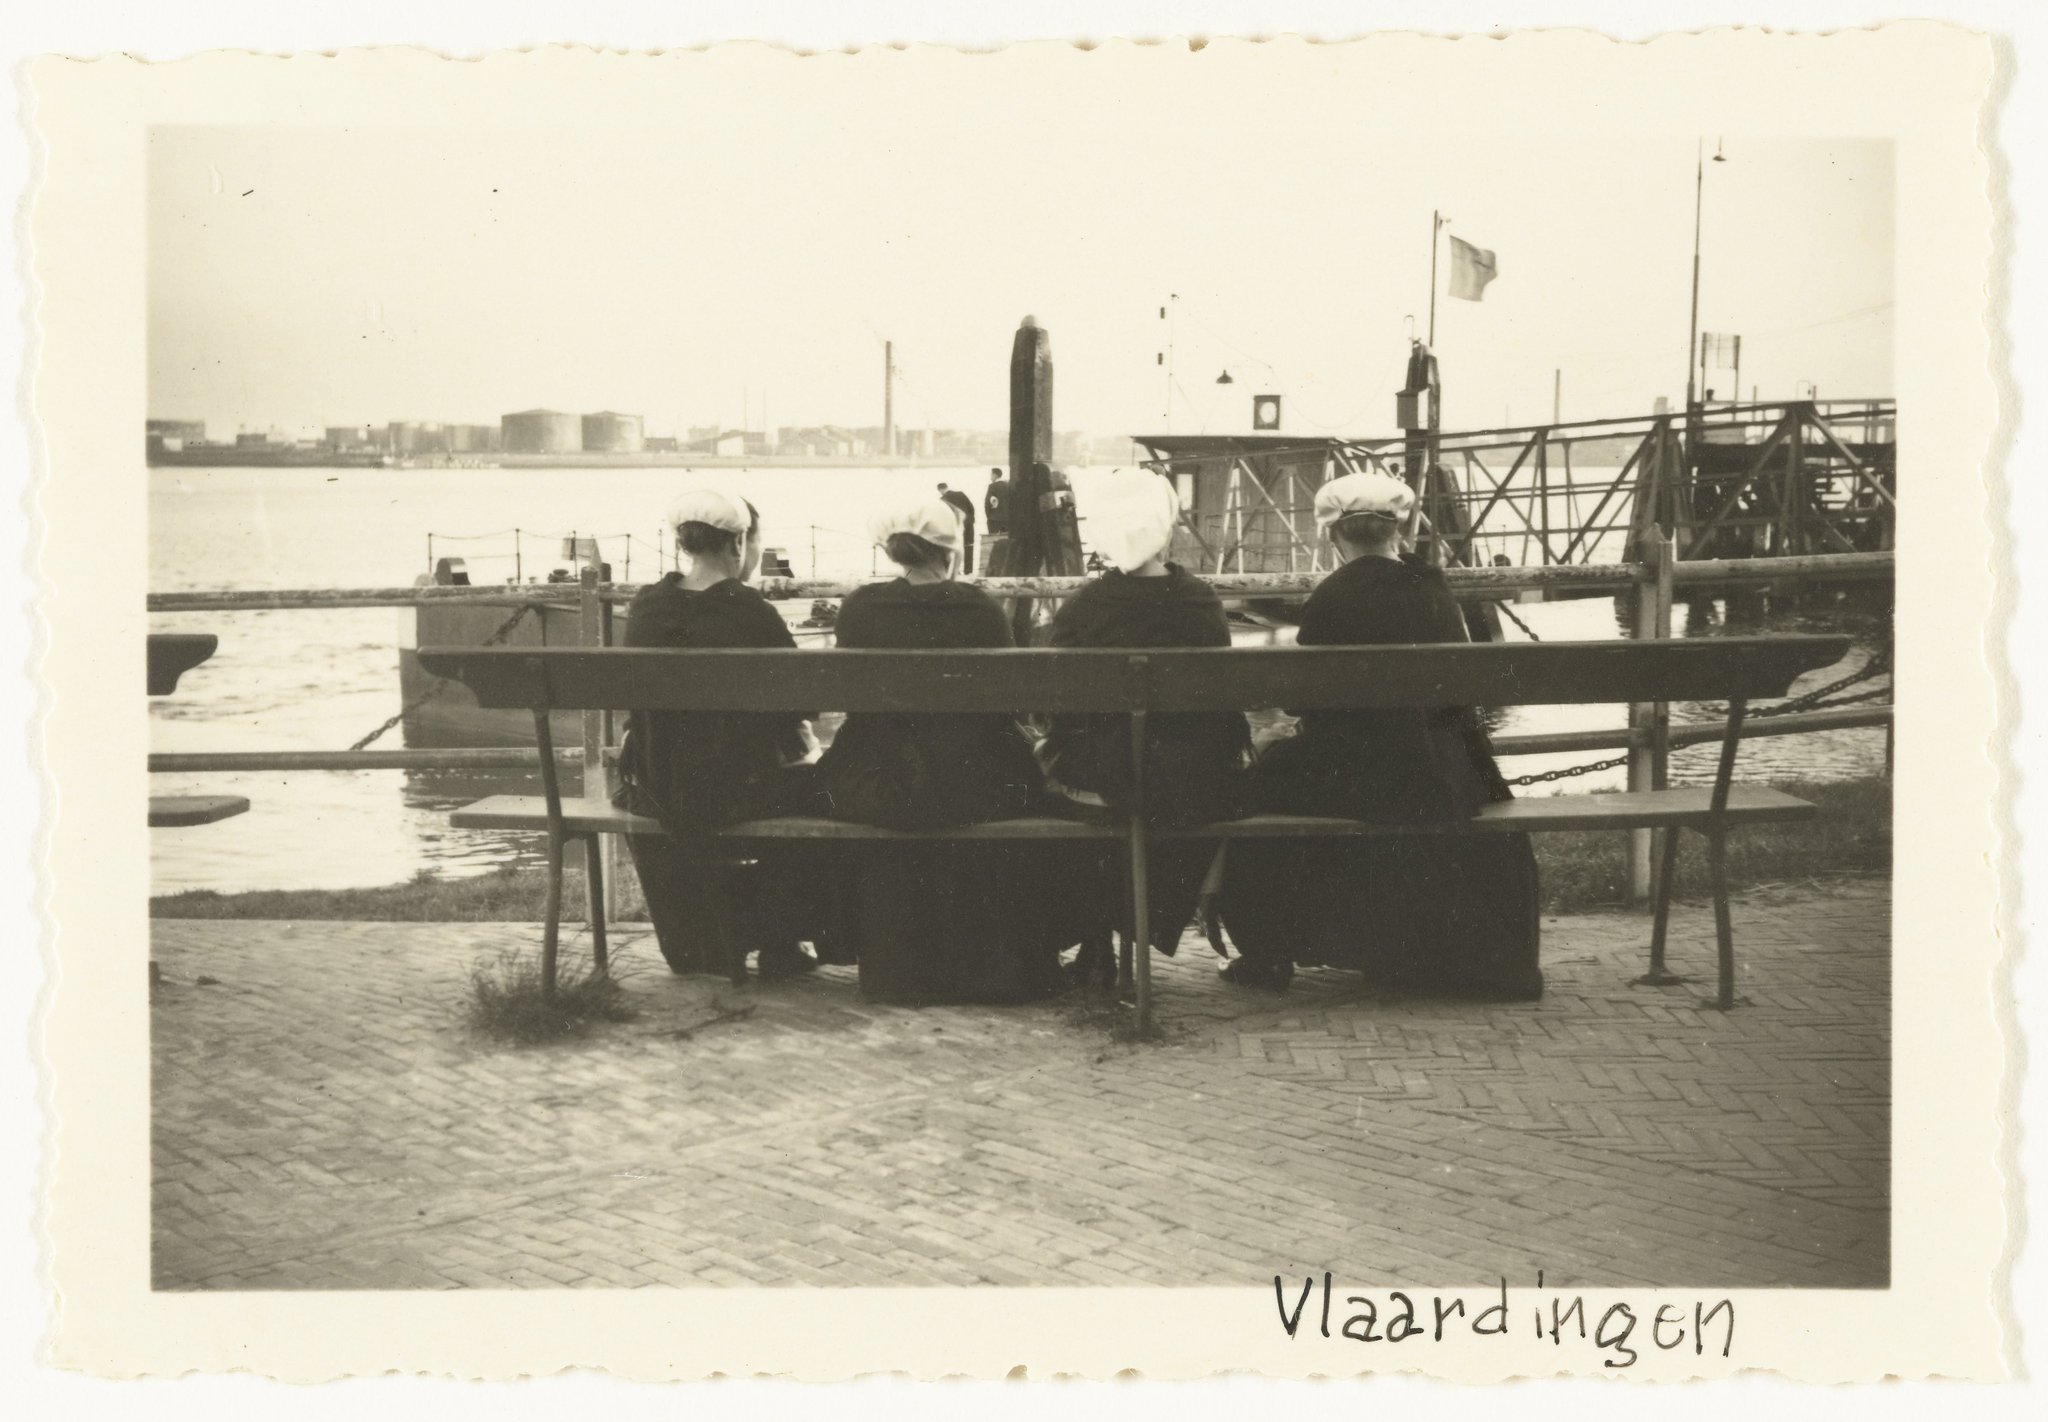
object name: photograph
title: Vier vrouwen op een bankje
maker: Anonymous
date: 1940-1941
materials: photographic support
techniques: gelatin silver print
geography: vlaardingen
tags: occupier and civilians, occupation ~ war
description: Vier vrouwen in lokale dracht zitten op een bankje in de haven. Op de achtergrond olietanks. Een gekochte foto?